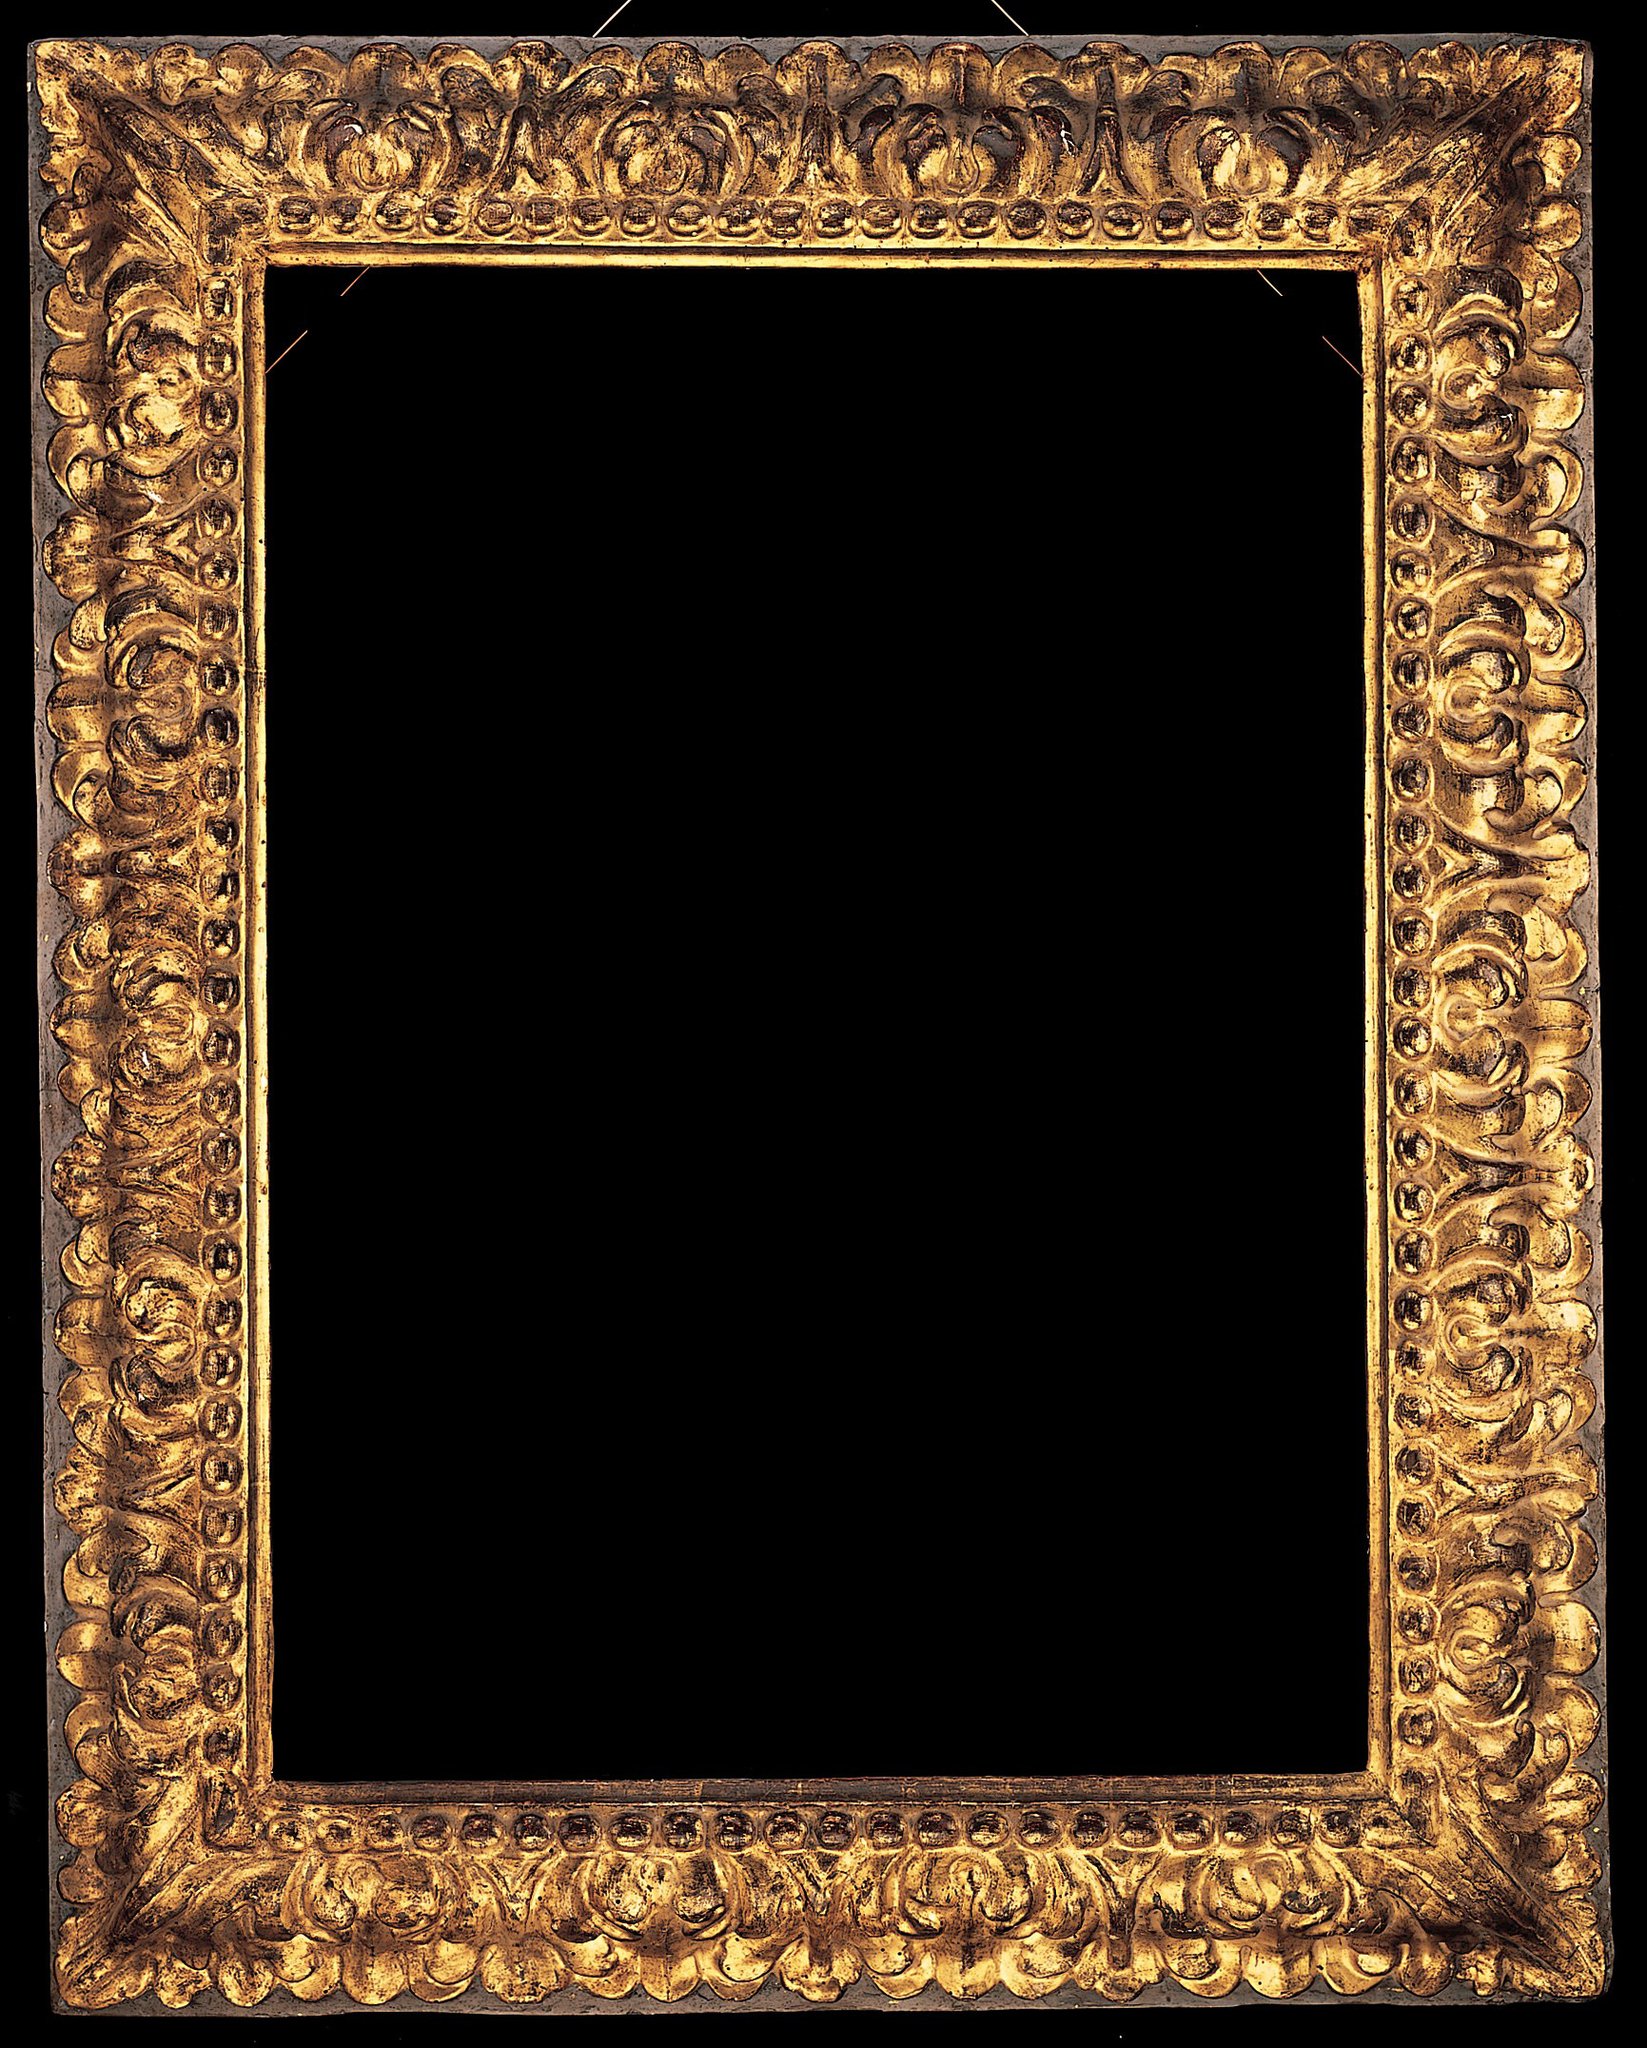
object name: frame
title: Reverse ogee frame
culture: southern italian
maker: southern italy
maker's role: artist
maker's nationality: southern italy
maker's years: 1670-1729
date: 1667-1733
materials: wood